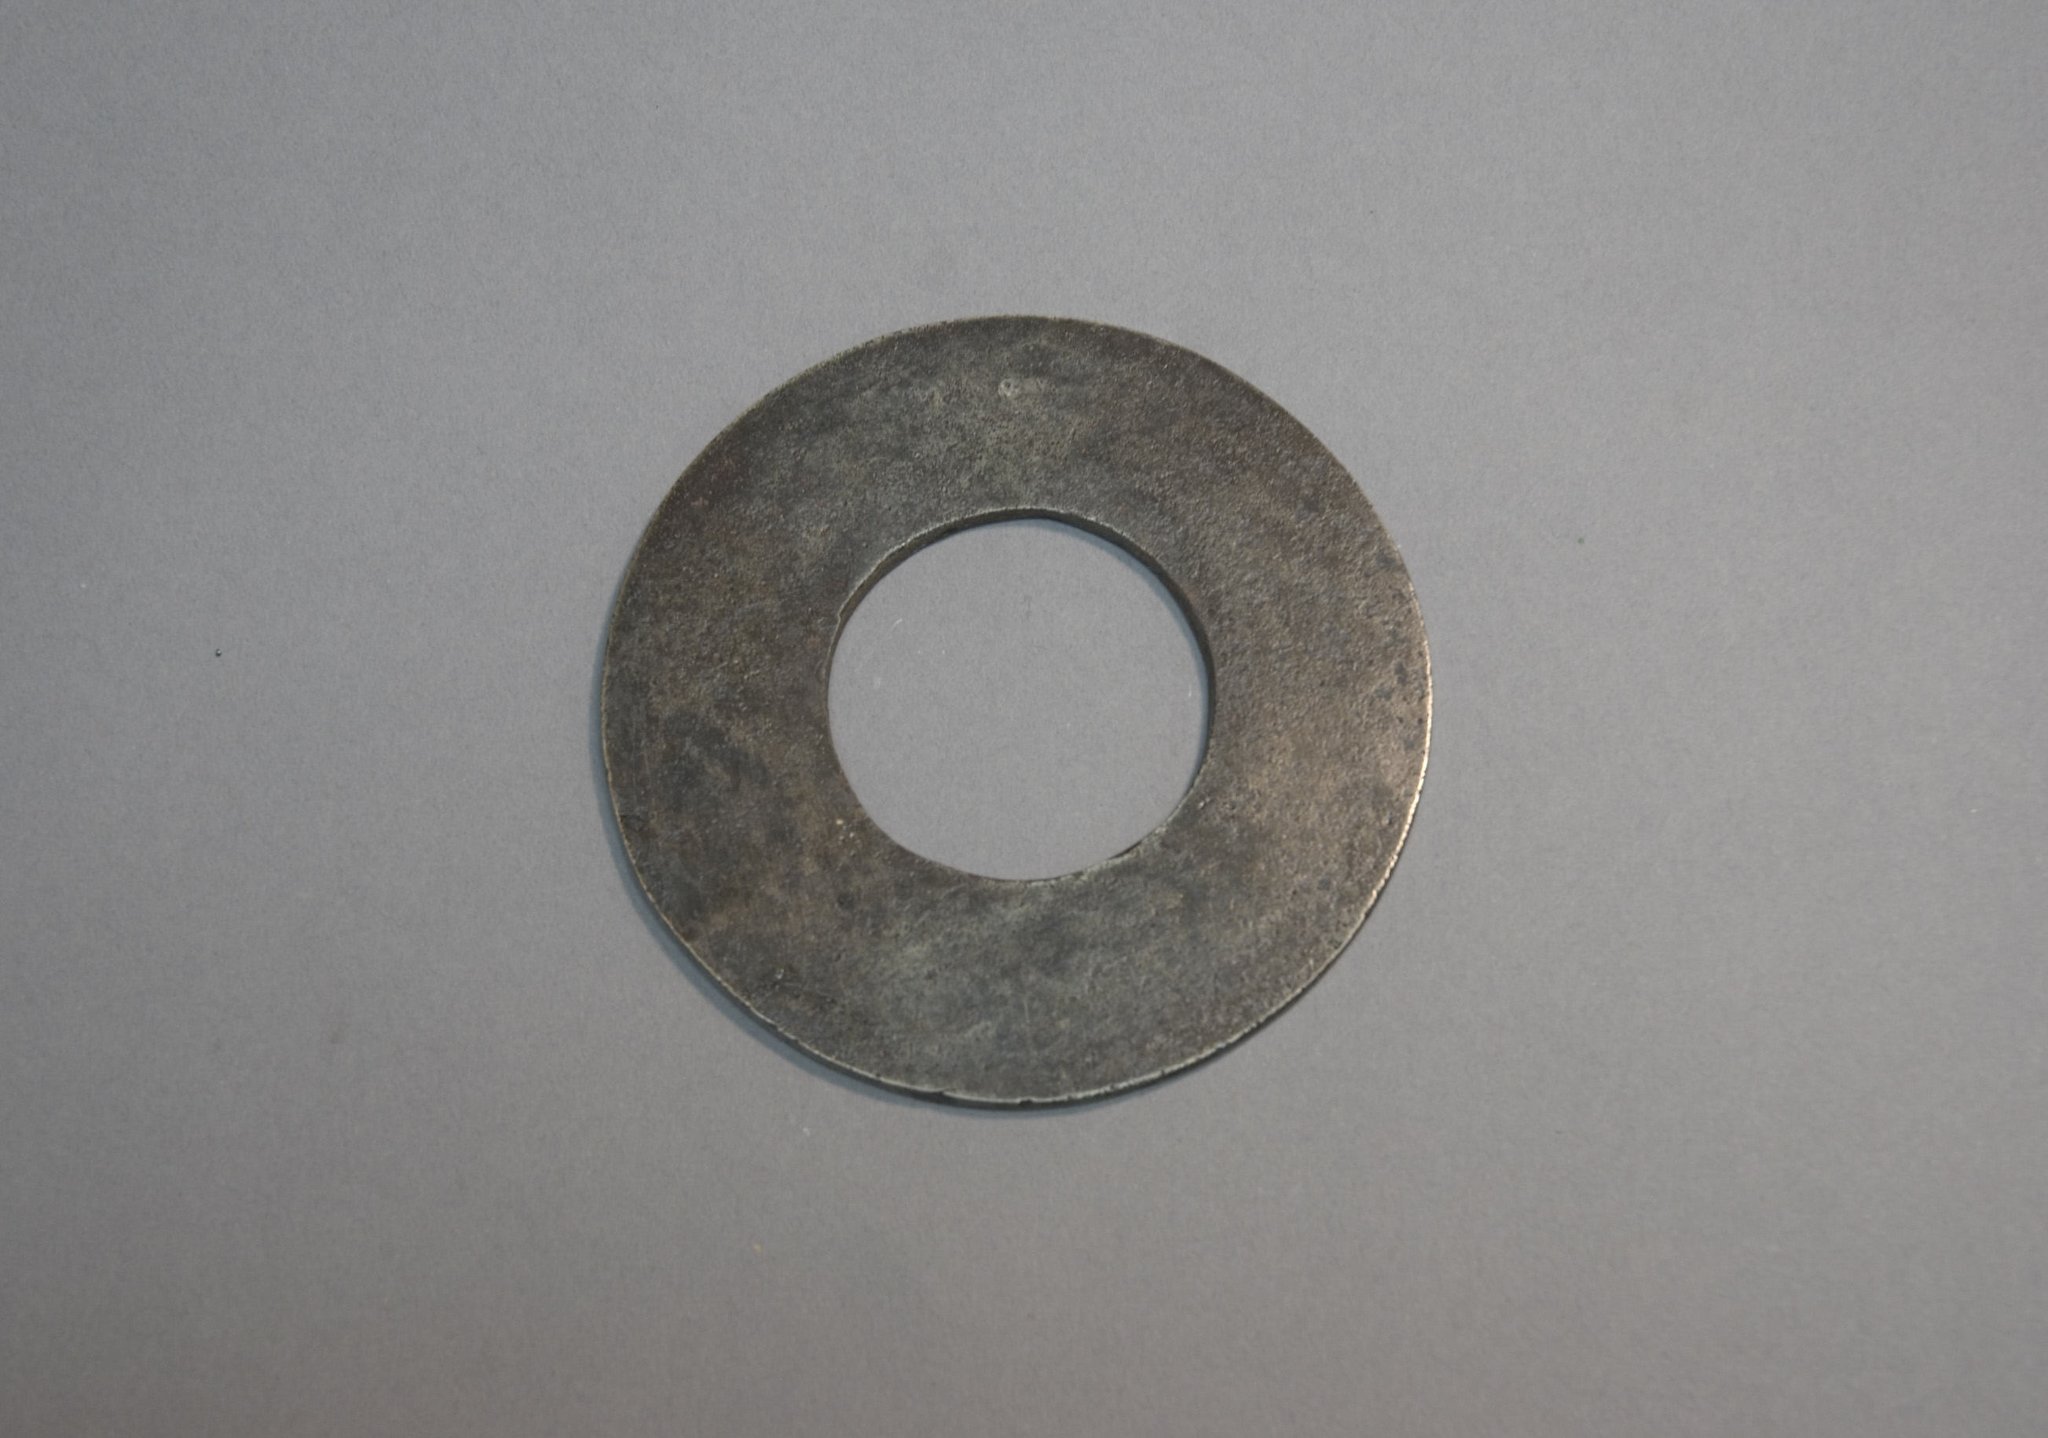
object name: jade carving tool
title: Template for Carving Jade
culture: chinese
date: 1901-2000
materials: iron